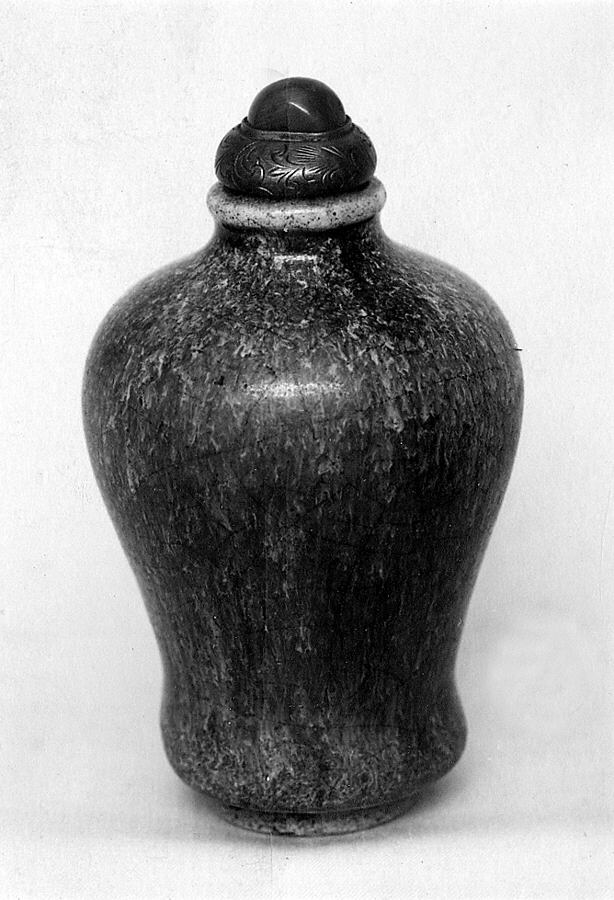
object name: snuff bottle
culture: chinese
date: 1723-1735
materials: porcelain